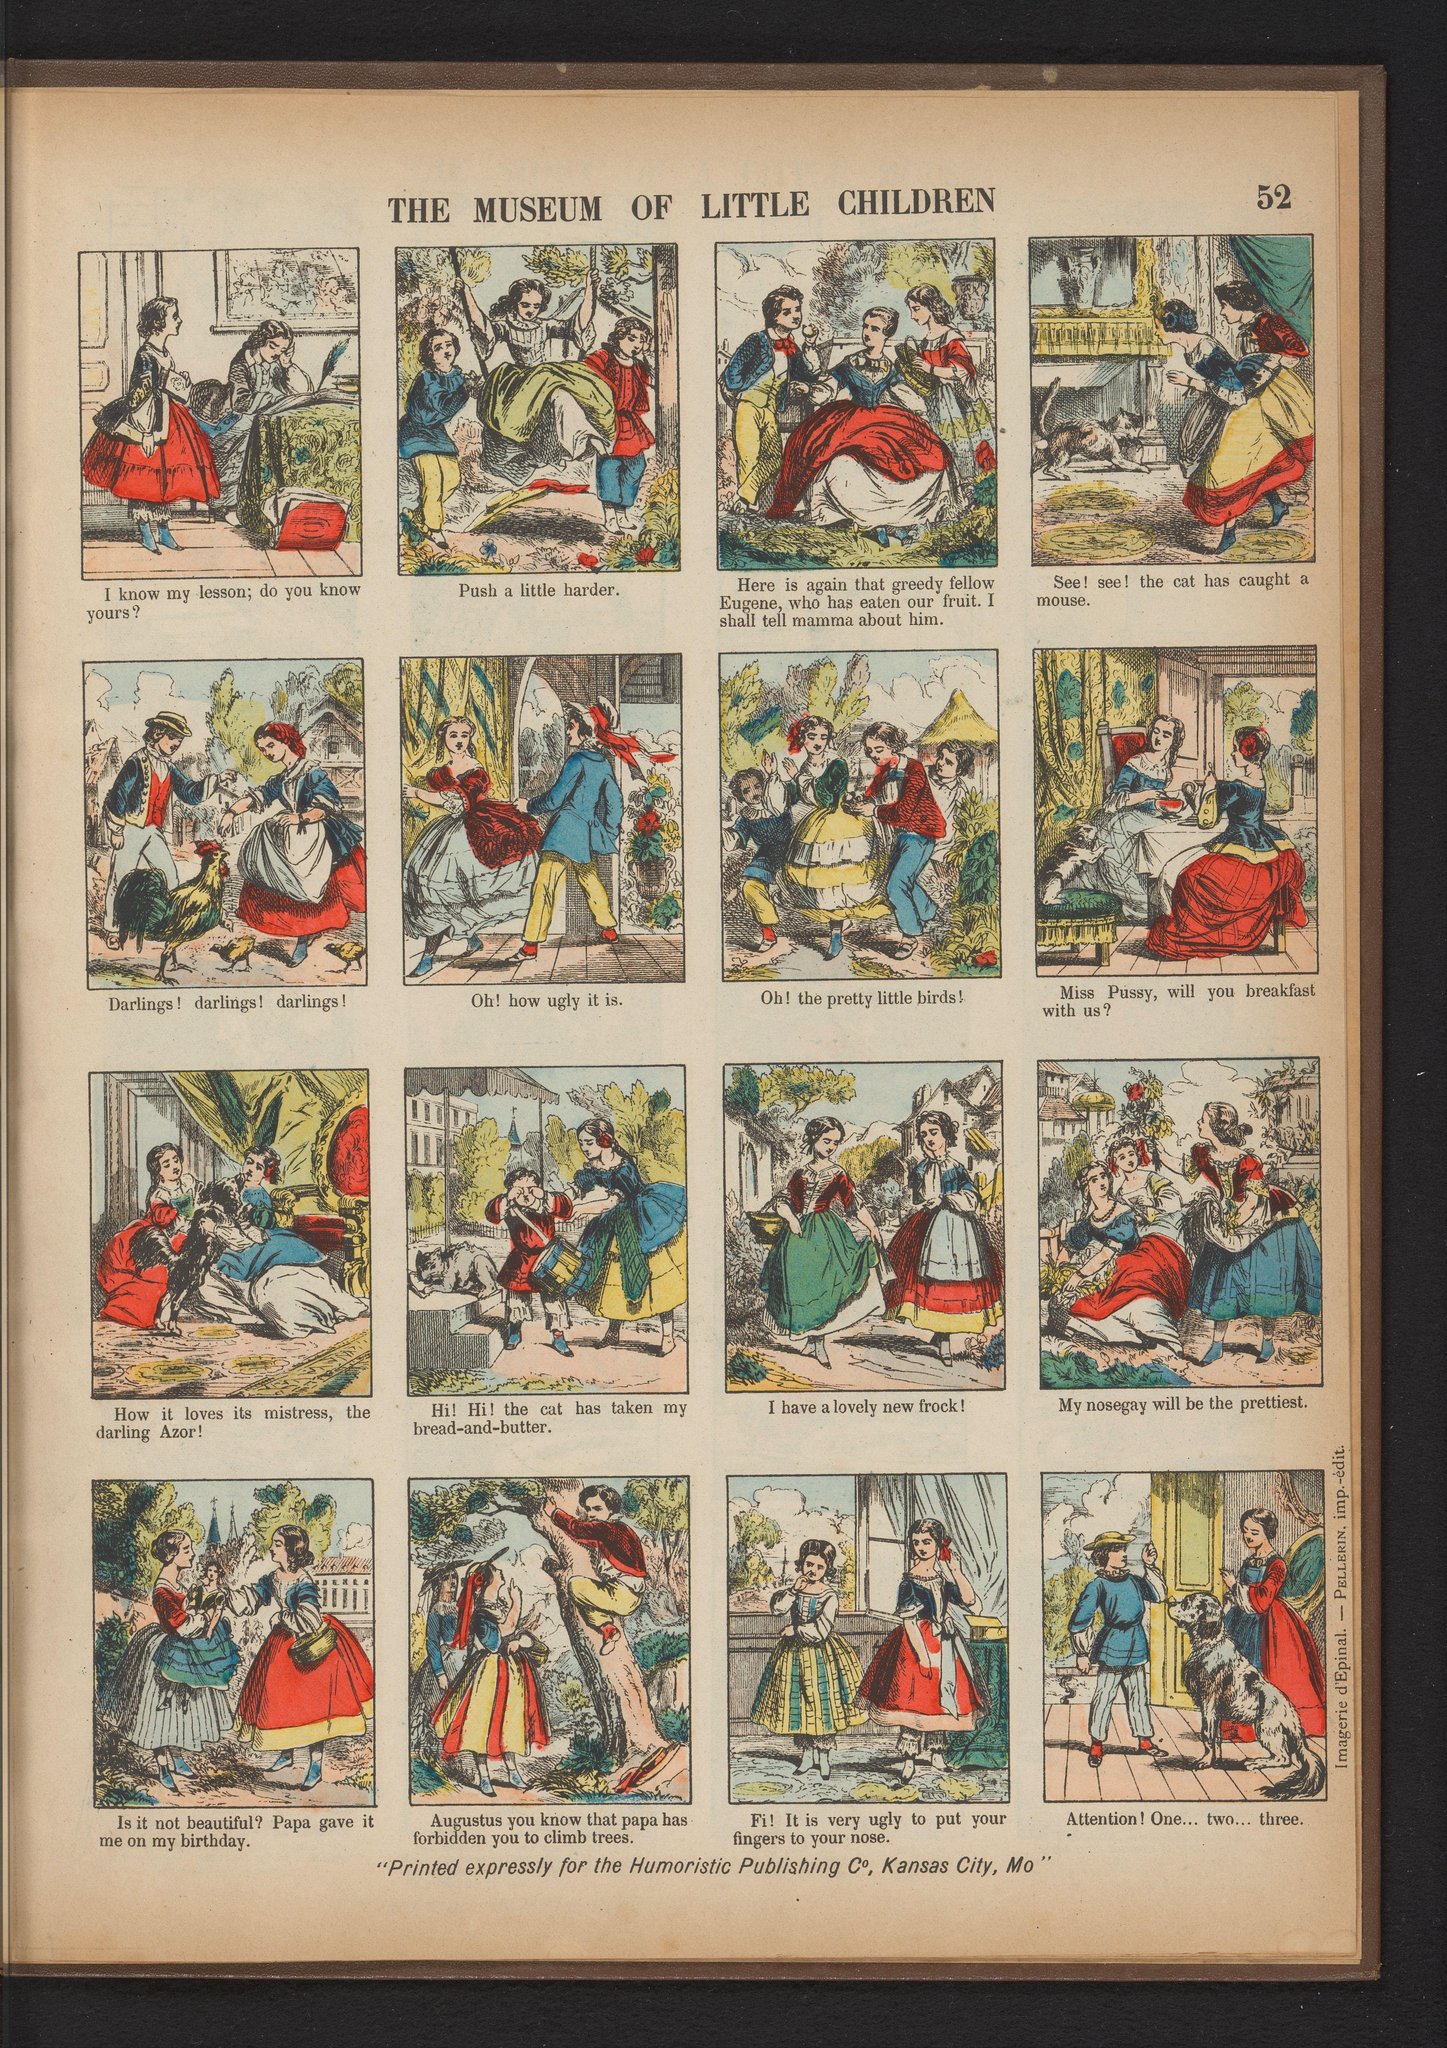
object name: print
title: Contes des fées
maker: Anonymous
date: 1893-1894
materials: paper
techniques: colour, letterpress printing, lithograph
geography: epinal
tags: education, child between toddler and youth (of undetermined sex)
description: Blad met zestien voorstellingen van kinderen in diverse situaties. Onder elke voorstelling een onderschrift in het Engels. Deze prent maakt deel uit van een album.